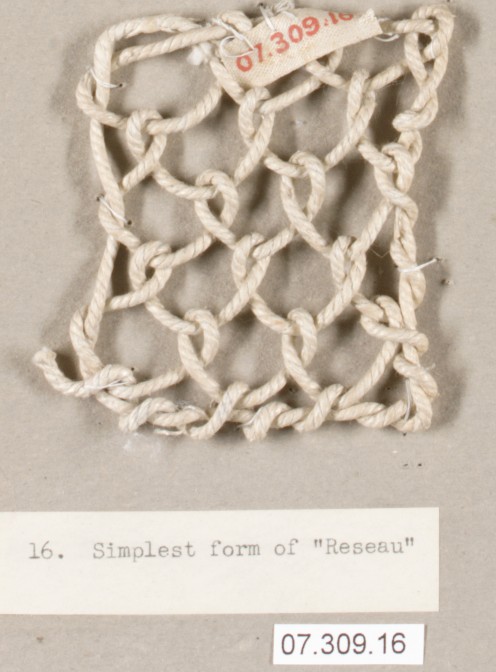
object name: stitch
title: Example of lace stitch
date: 1801-2000